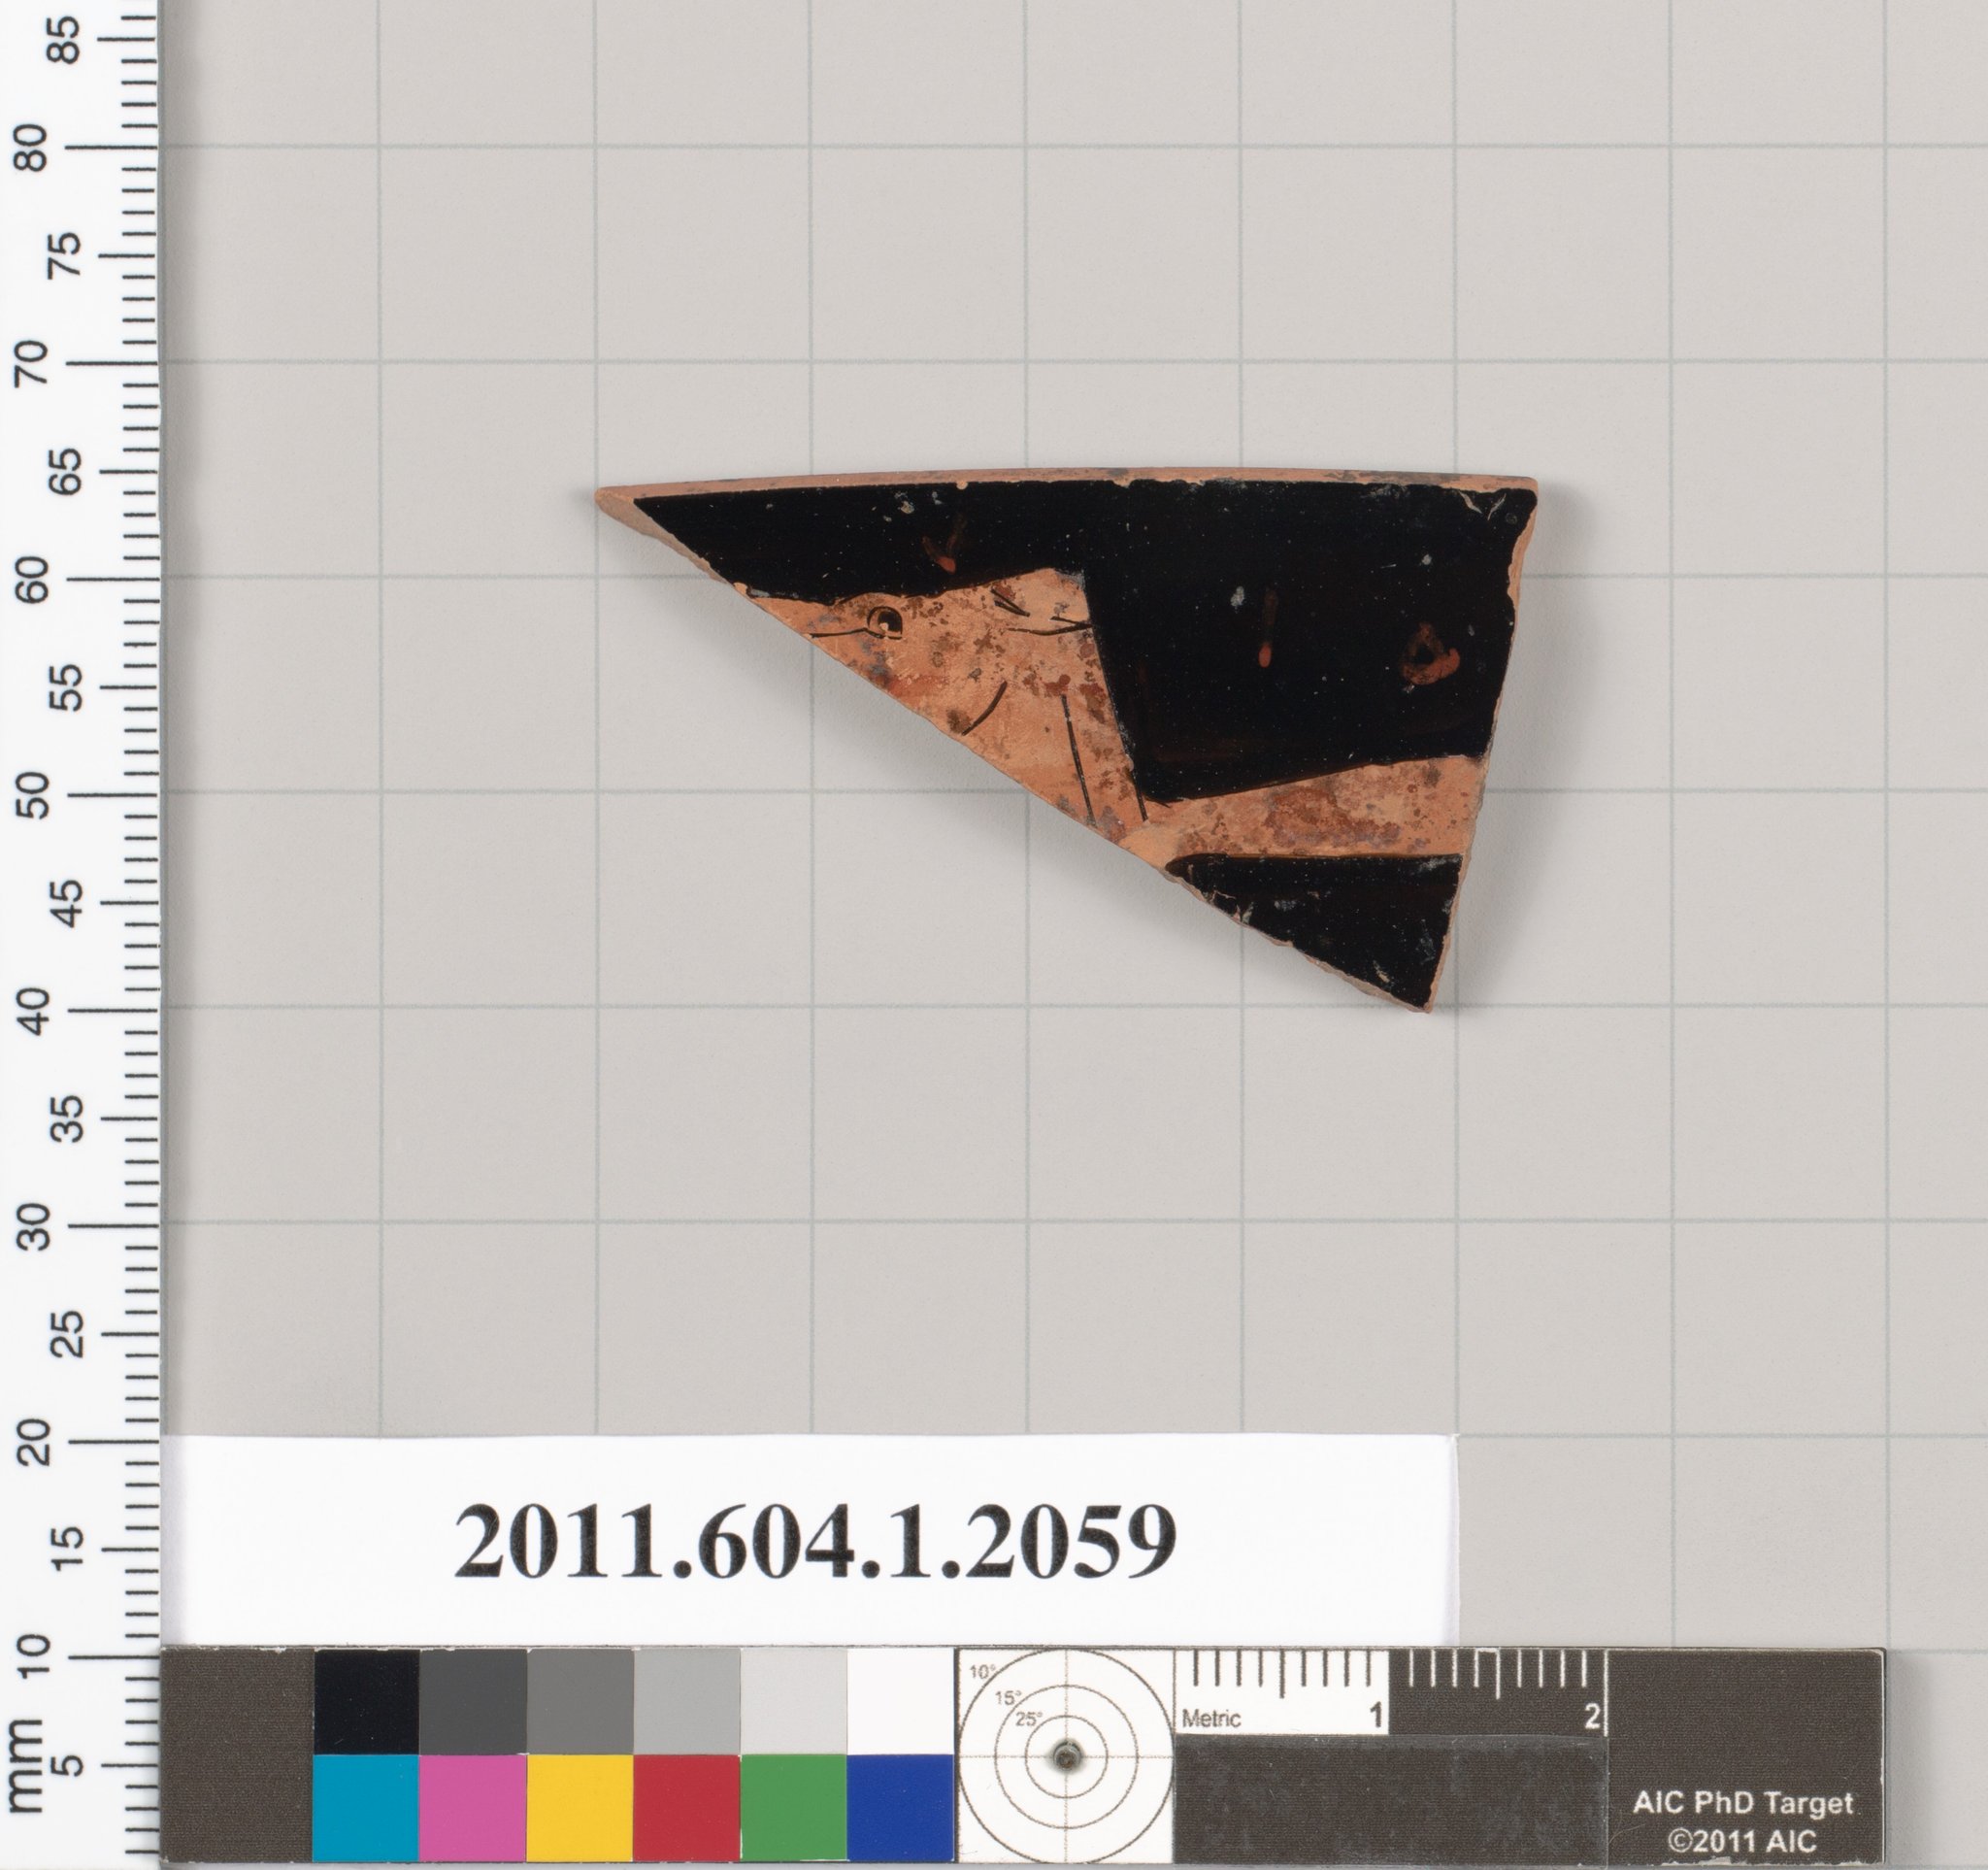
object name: kylix fragment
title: Terracotta rim fragment of a kylix (drinking cup)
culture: greek, attic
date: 475-451 BCE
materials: terracotta